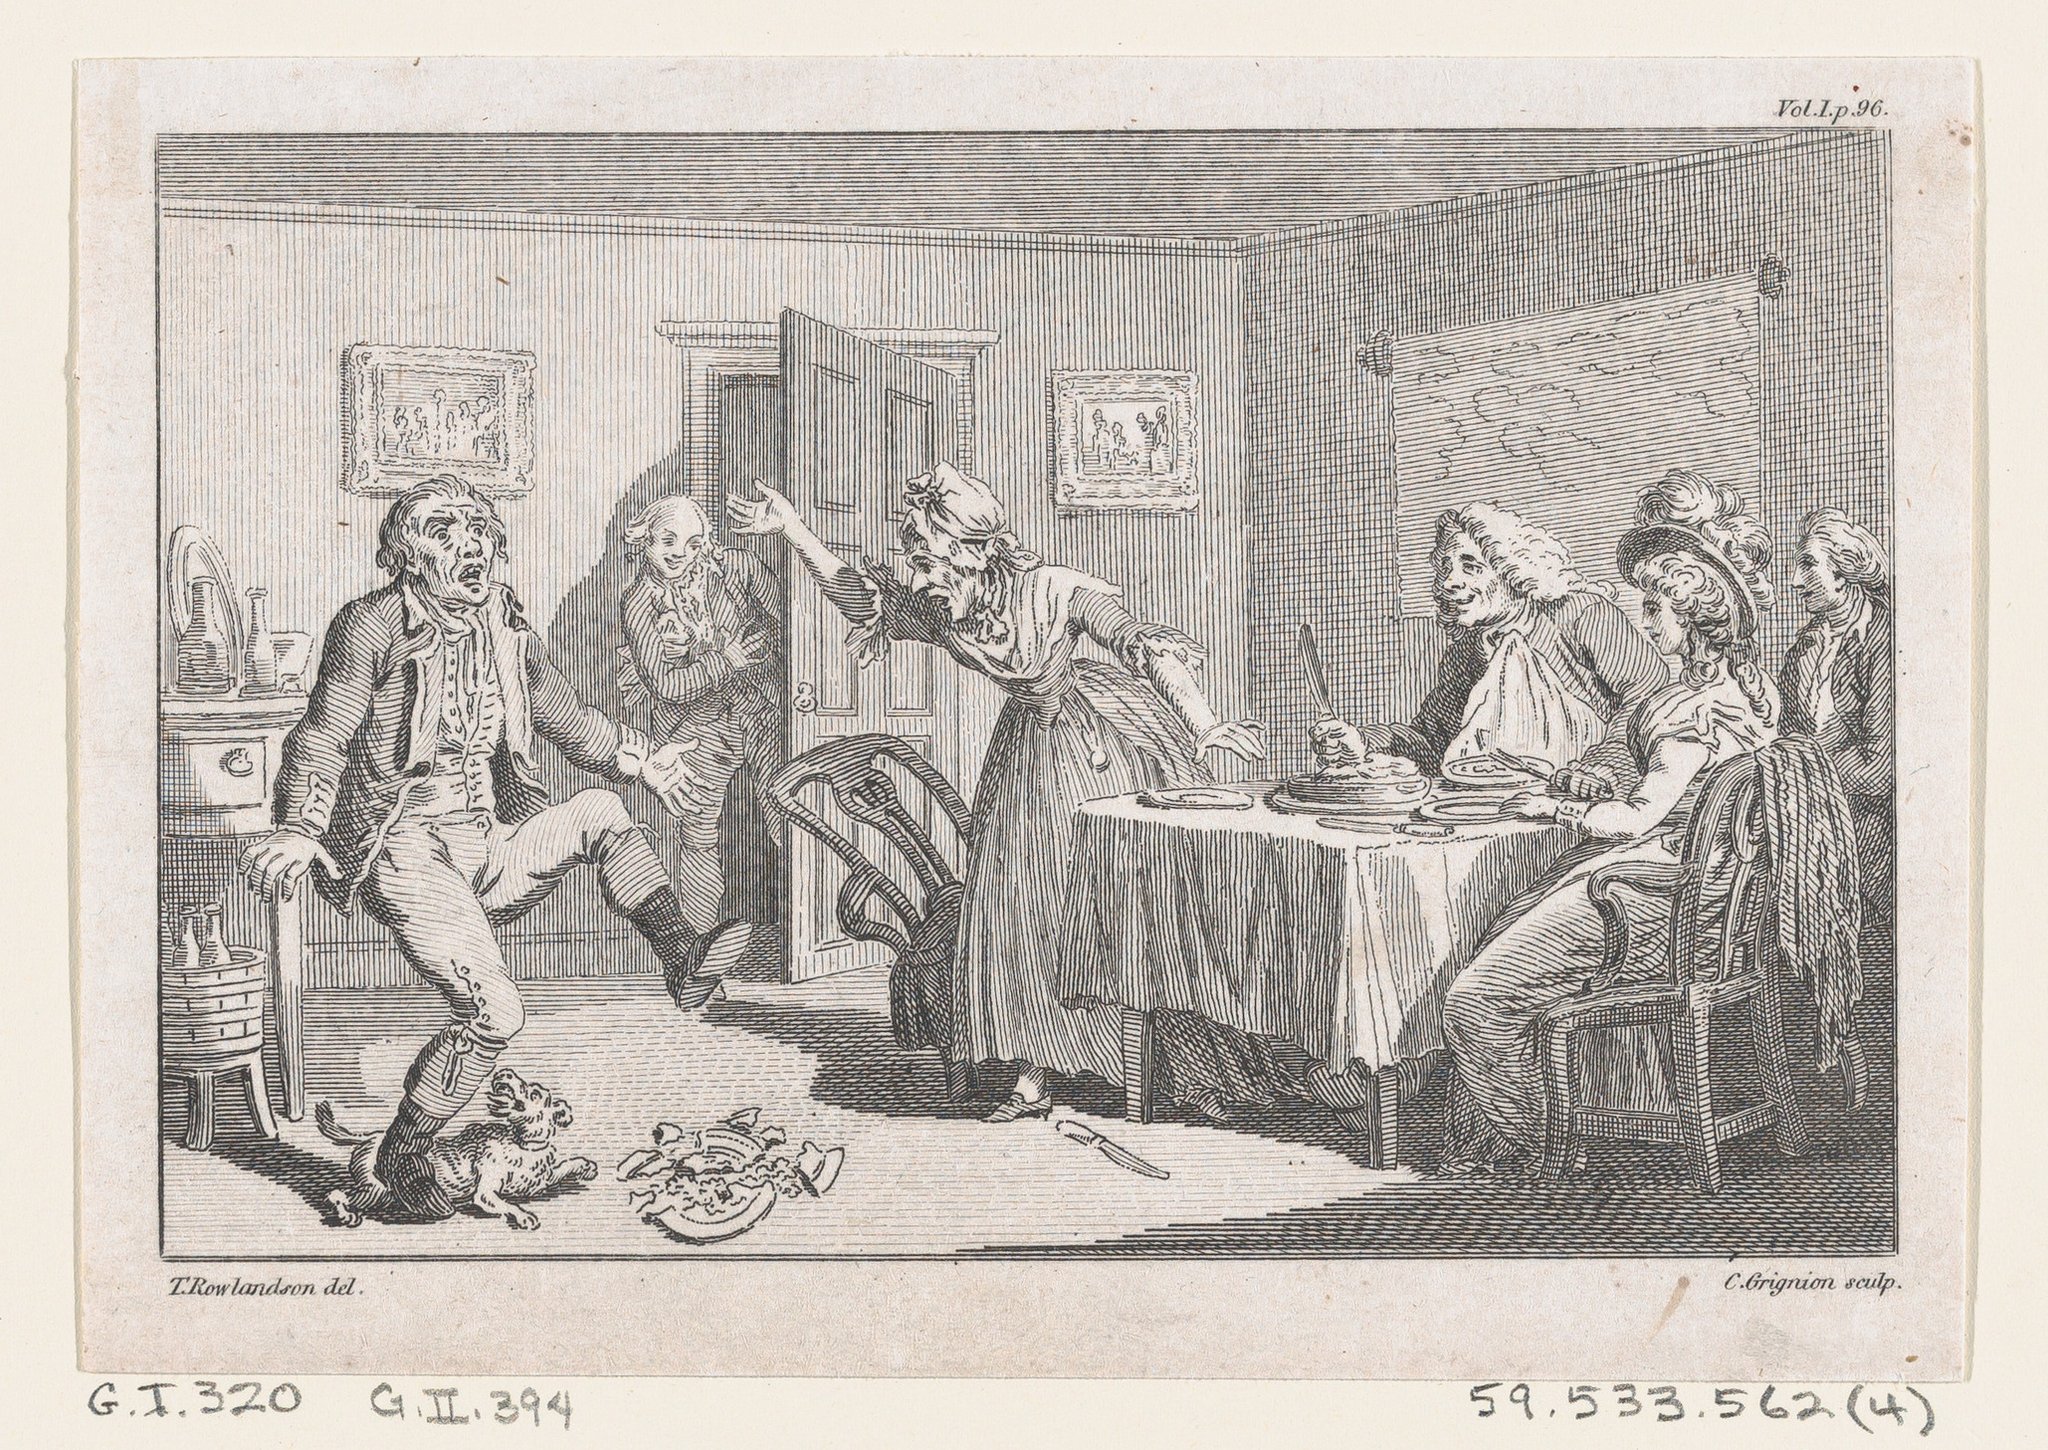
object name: print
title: Humphry Clinker Smashing a Dish at Dinner..., an illustration from Tobias Smollett's "The Expedition of Humphry Clinker" (London, 1793), Vol. 1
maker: charles grignion, i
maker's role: artist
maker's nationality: british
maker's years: 1710-1810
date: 1793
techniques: engraving, etching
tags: men,women,dogs